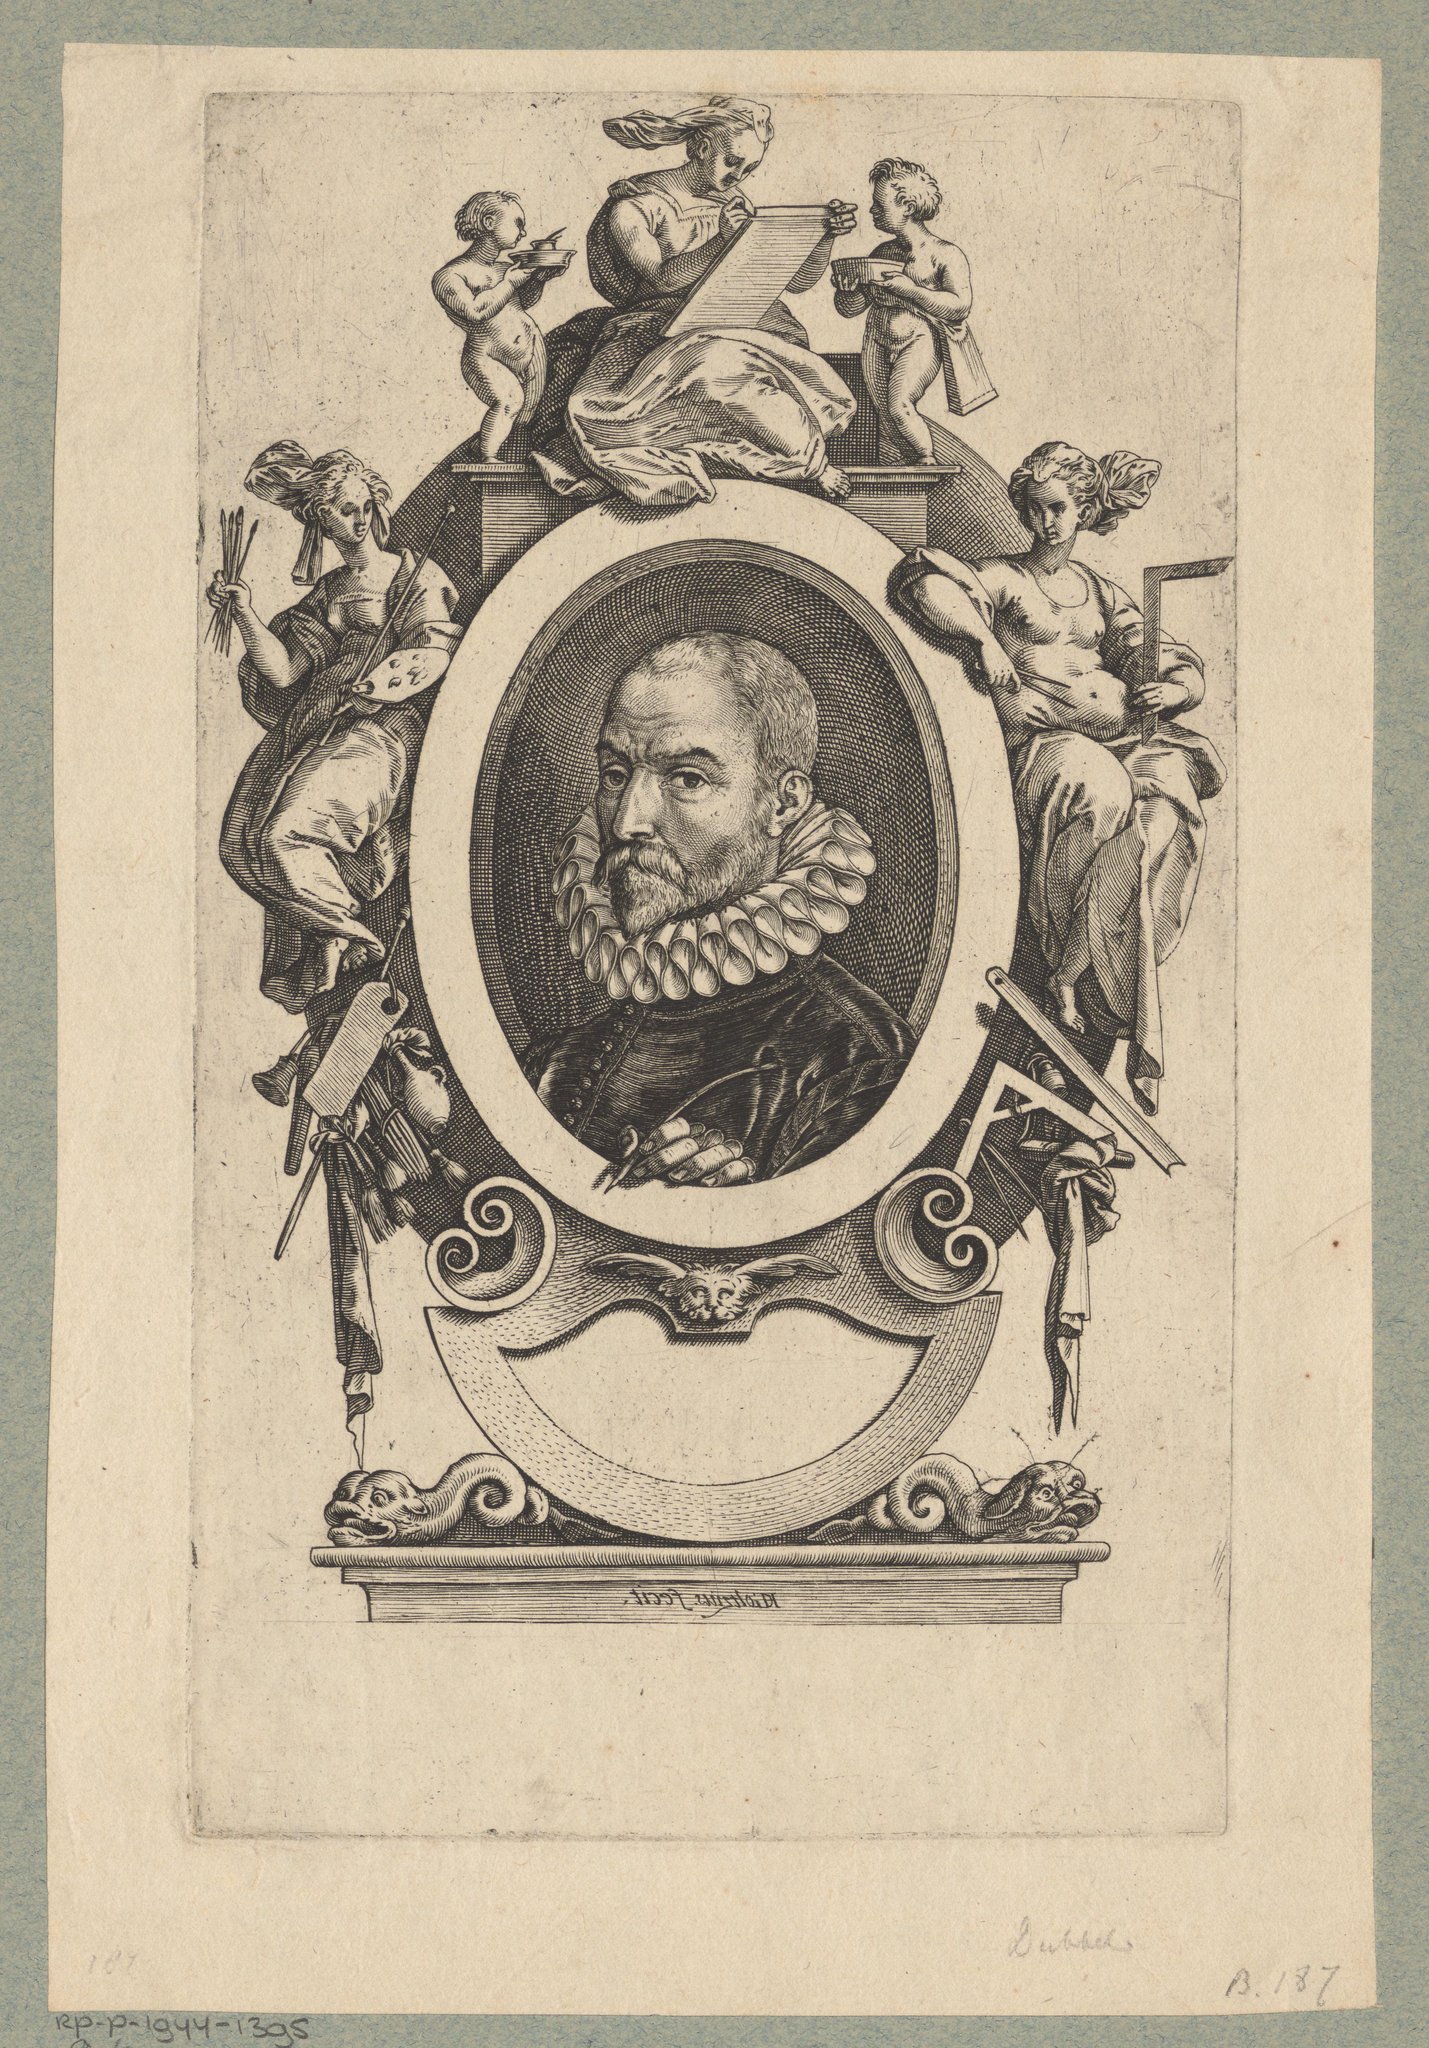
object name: print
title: Portret van Jan van der Straet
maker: hendrick goltzius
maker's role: draughtsman, painter, print maker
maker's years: 1558-1617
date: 1568-1600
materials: paper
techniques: engraving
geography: haarlem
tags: bruges, draughtsman, jan van der straet, 'pictura', symbolic representations, allegories and emblems ~ painting; 'pittura' (ripa), historical persons, portrait, self-portrait of artist, 'architectura', symbolic representations, allegories and emblems ~ architecture; 'architettura' (ripa), symbolic representations, allegories and emblems ~ drawing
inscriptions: collector's mark: Lugt 3937